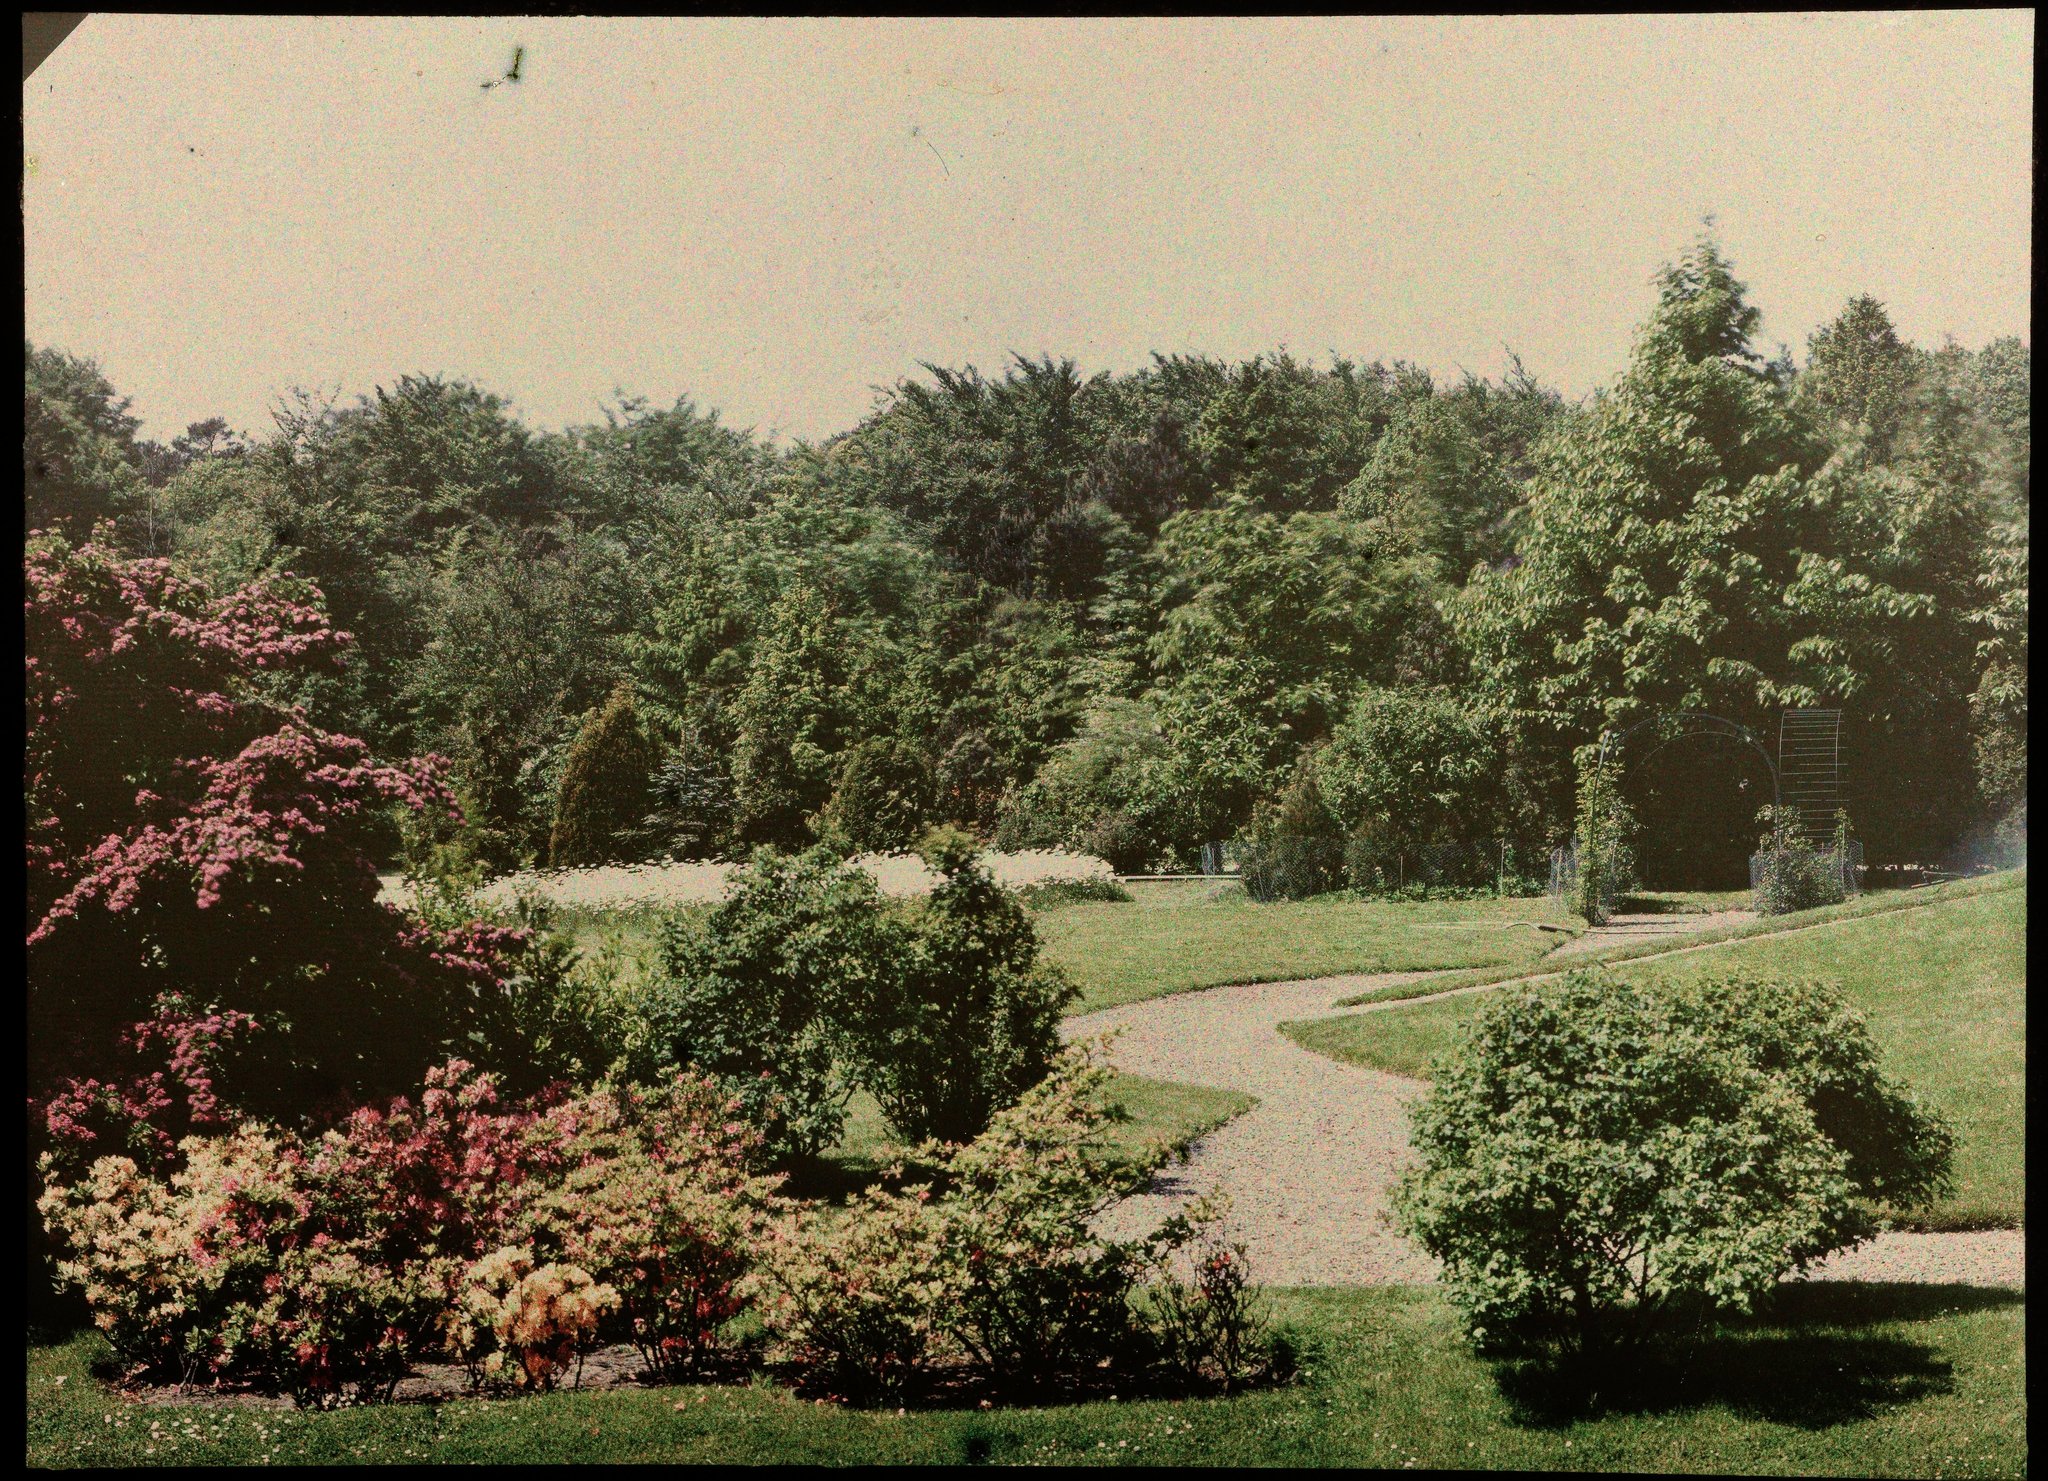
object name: color slide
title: Gezicht in een park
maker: adolphe burdet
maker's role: fotograaf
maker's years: 1860-1940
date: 1907-1930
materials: glass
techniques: autochrome process, slide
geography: netherlands